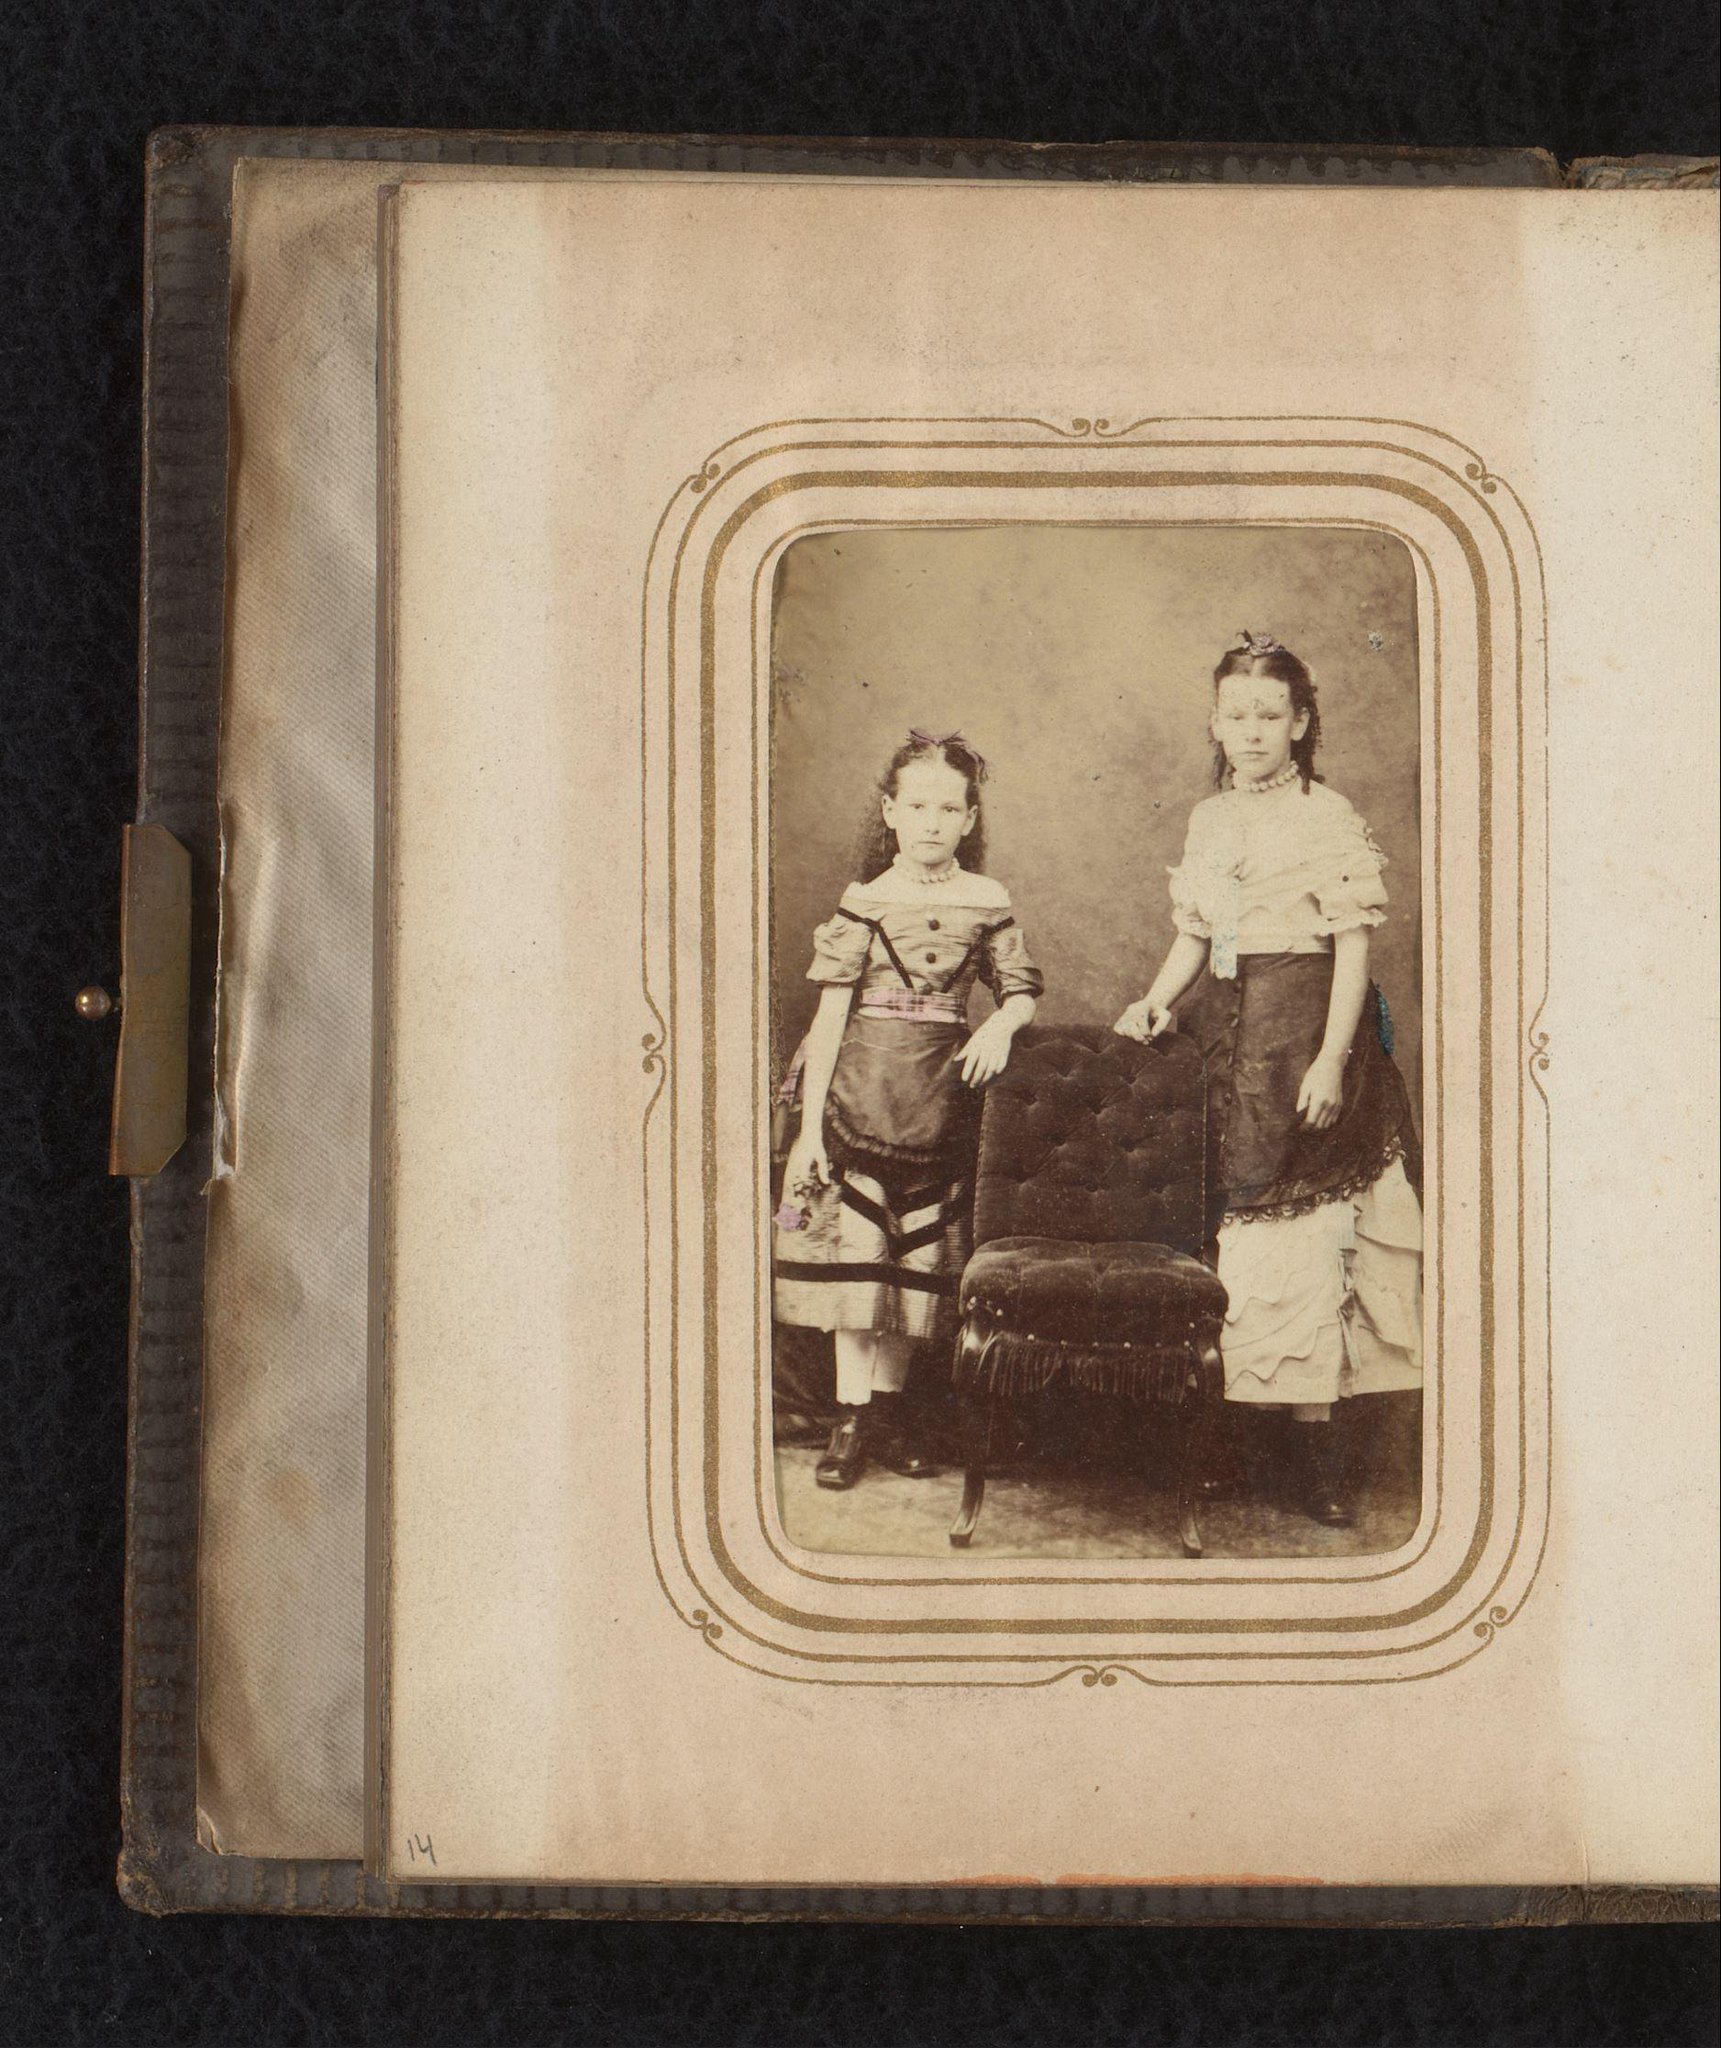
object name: album leaf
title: Portret van twee meisjes bij een stoel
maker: frederick argall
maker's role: fotograaf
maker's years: 1847-1900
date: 1860-1900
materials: cardboard, photographic support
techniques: albumen print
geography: truro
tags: girl (child between toddler and youth)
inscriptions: inscription: ‘Fredk. Argall/ Photographer/ High Cross/ Truro’